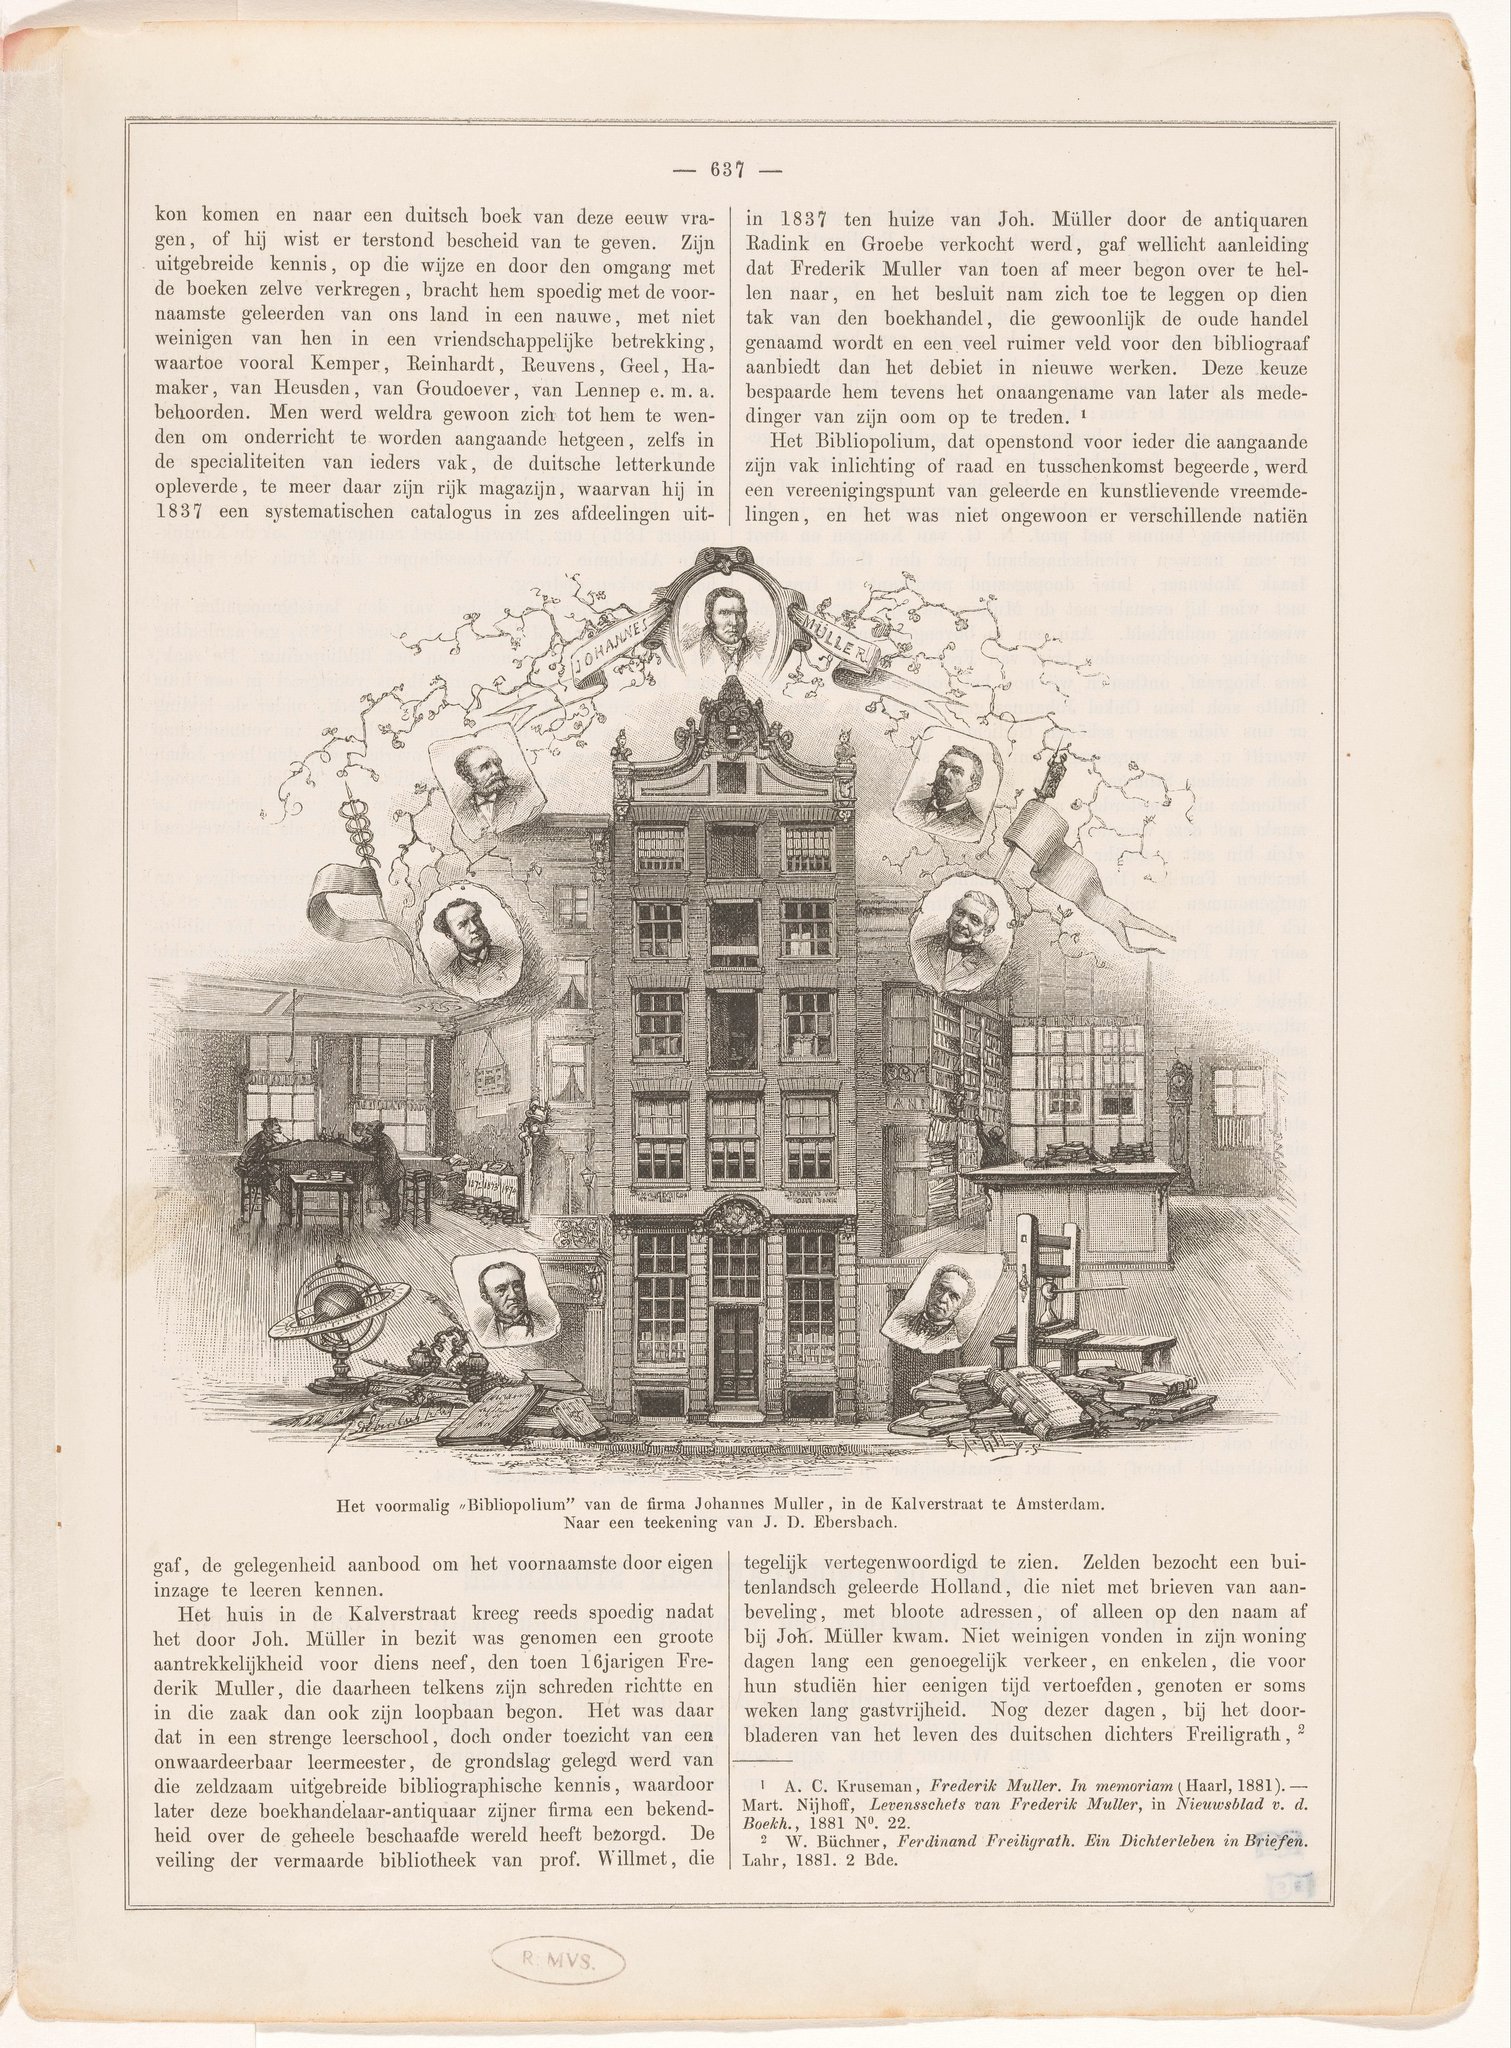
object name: print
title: Bibliopolium van Johannes Müller aan de Kalverstraat te Amsterdam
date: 1884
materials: paper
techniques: letterpress printing, engraving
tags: kalverstraat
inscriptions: collector's mark: Lugt 2228, collector's mark: Lugt 4780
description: Gevel van het pand aan de Kalverstraat. Aan weerszijden details van het interieur en portretten van Johannes en Christiaan Müller en leden van het personeel.